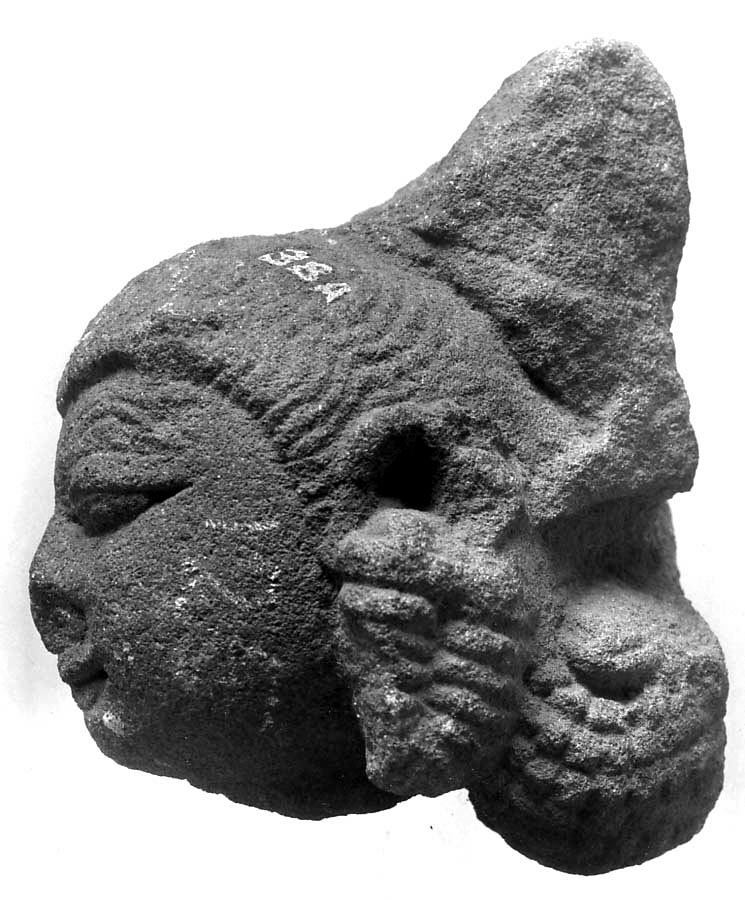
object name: head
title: Head of a Female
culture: indian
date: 901-1000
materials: stone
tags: heads,women